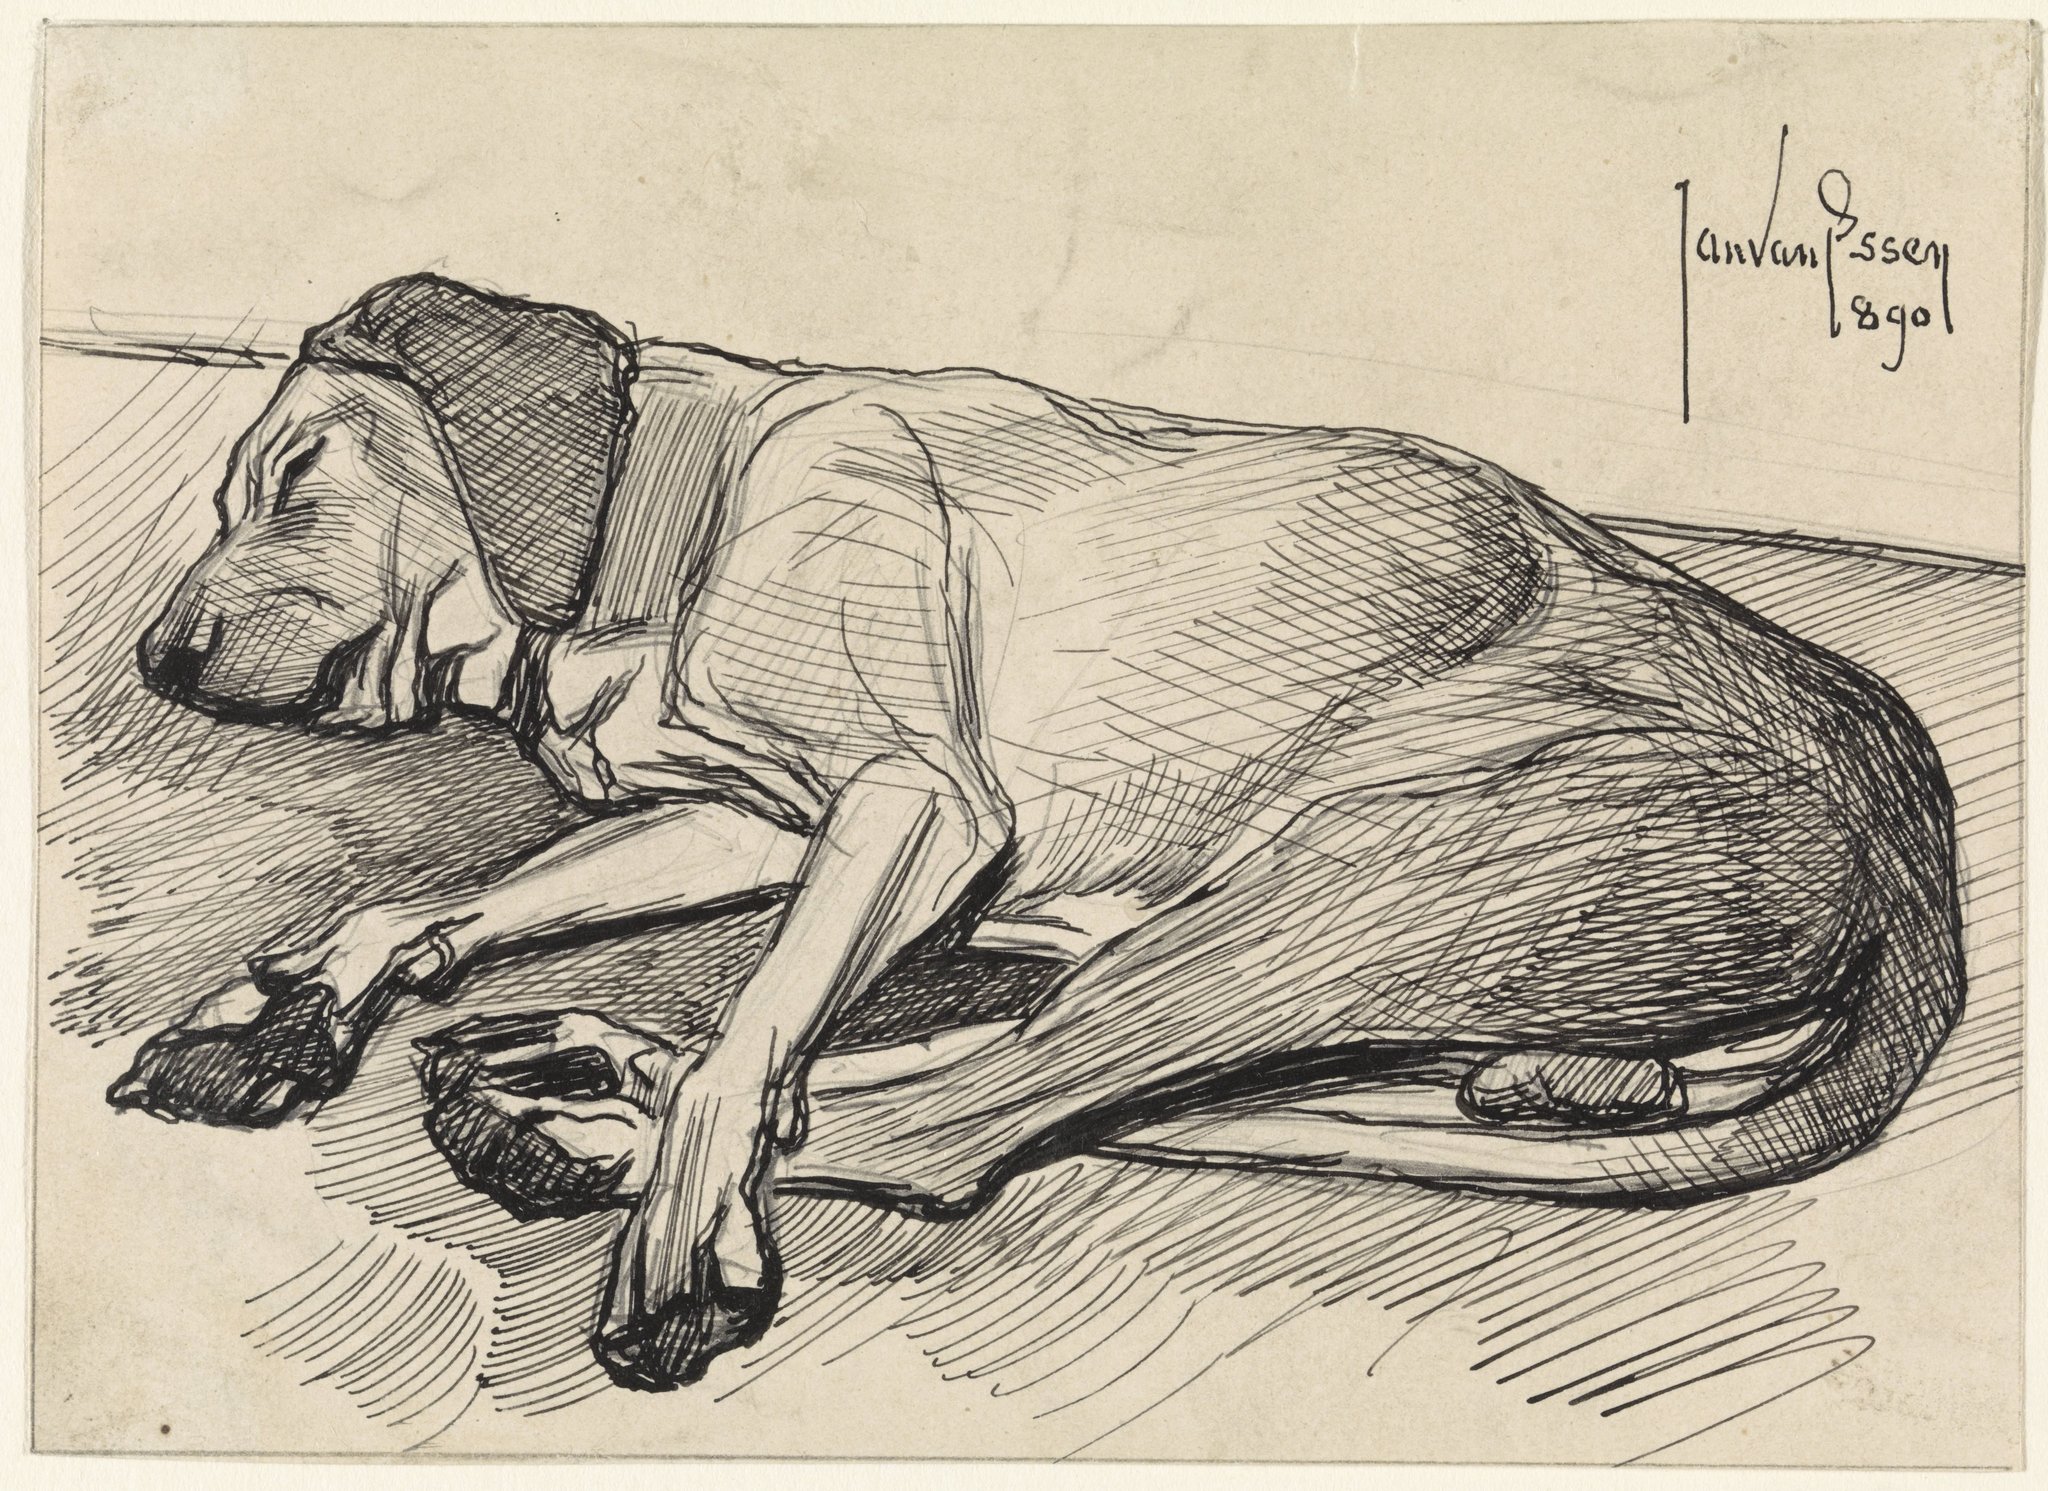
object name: drawing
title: Slapende hond, naar links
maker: jan van essen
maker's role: draughtsman, print maker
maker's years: 1854-1936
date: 1890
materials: ink, paper, pencil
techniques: pen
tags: dog